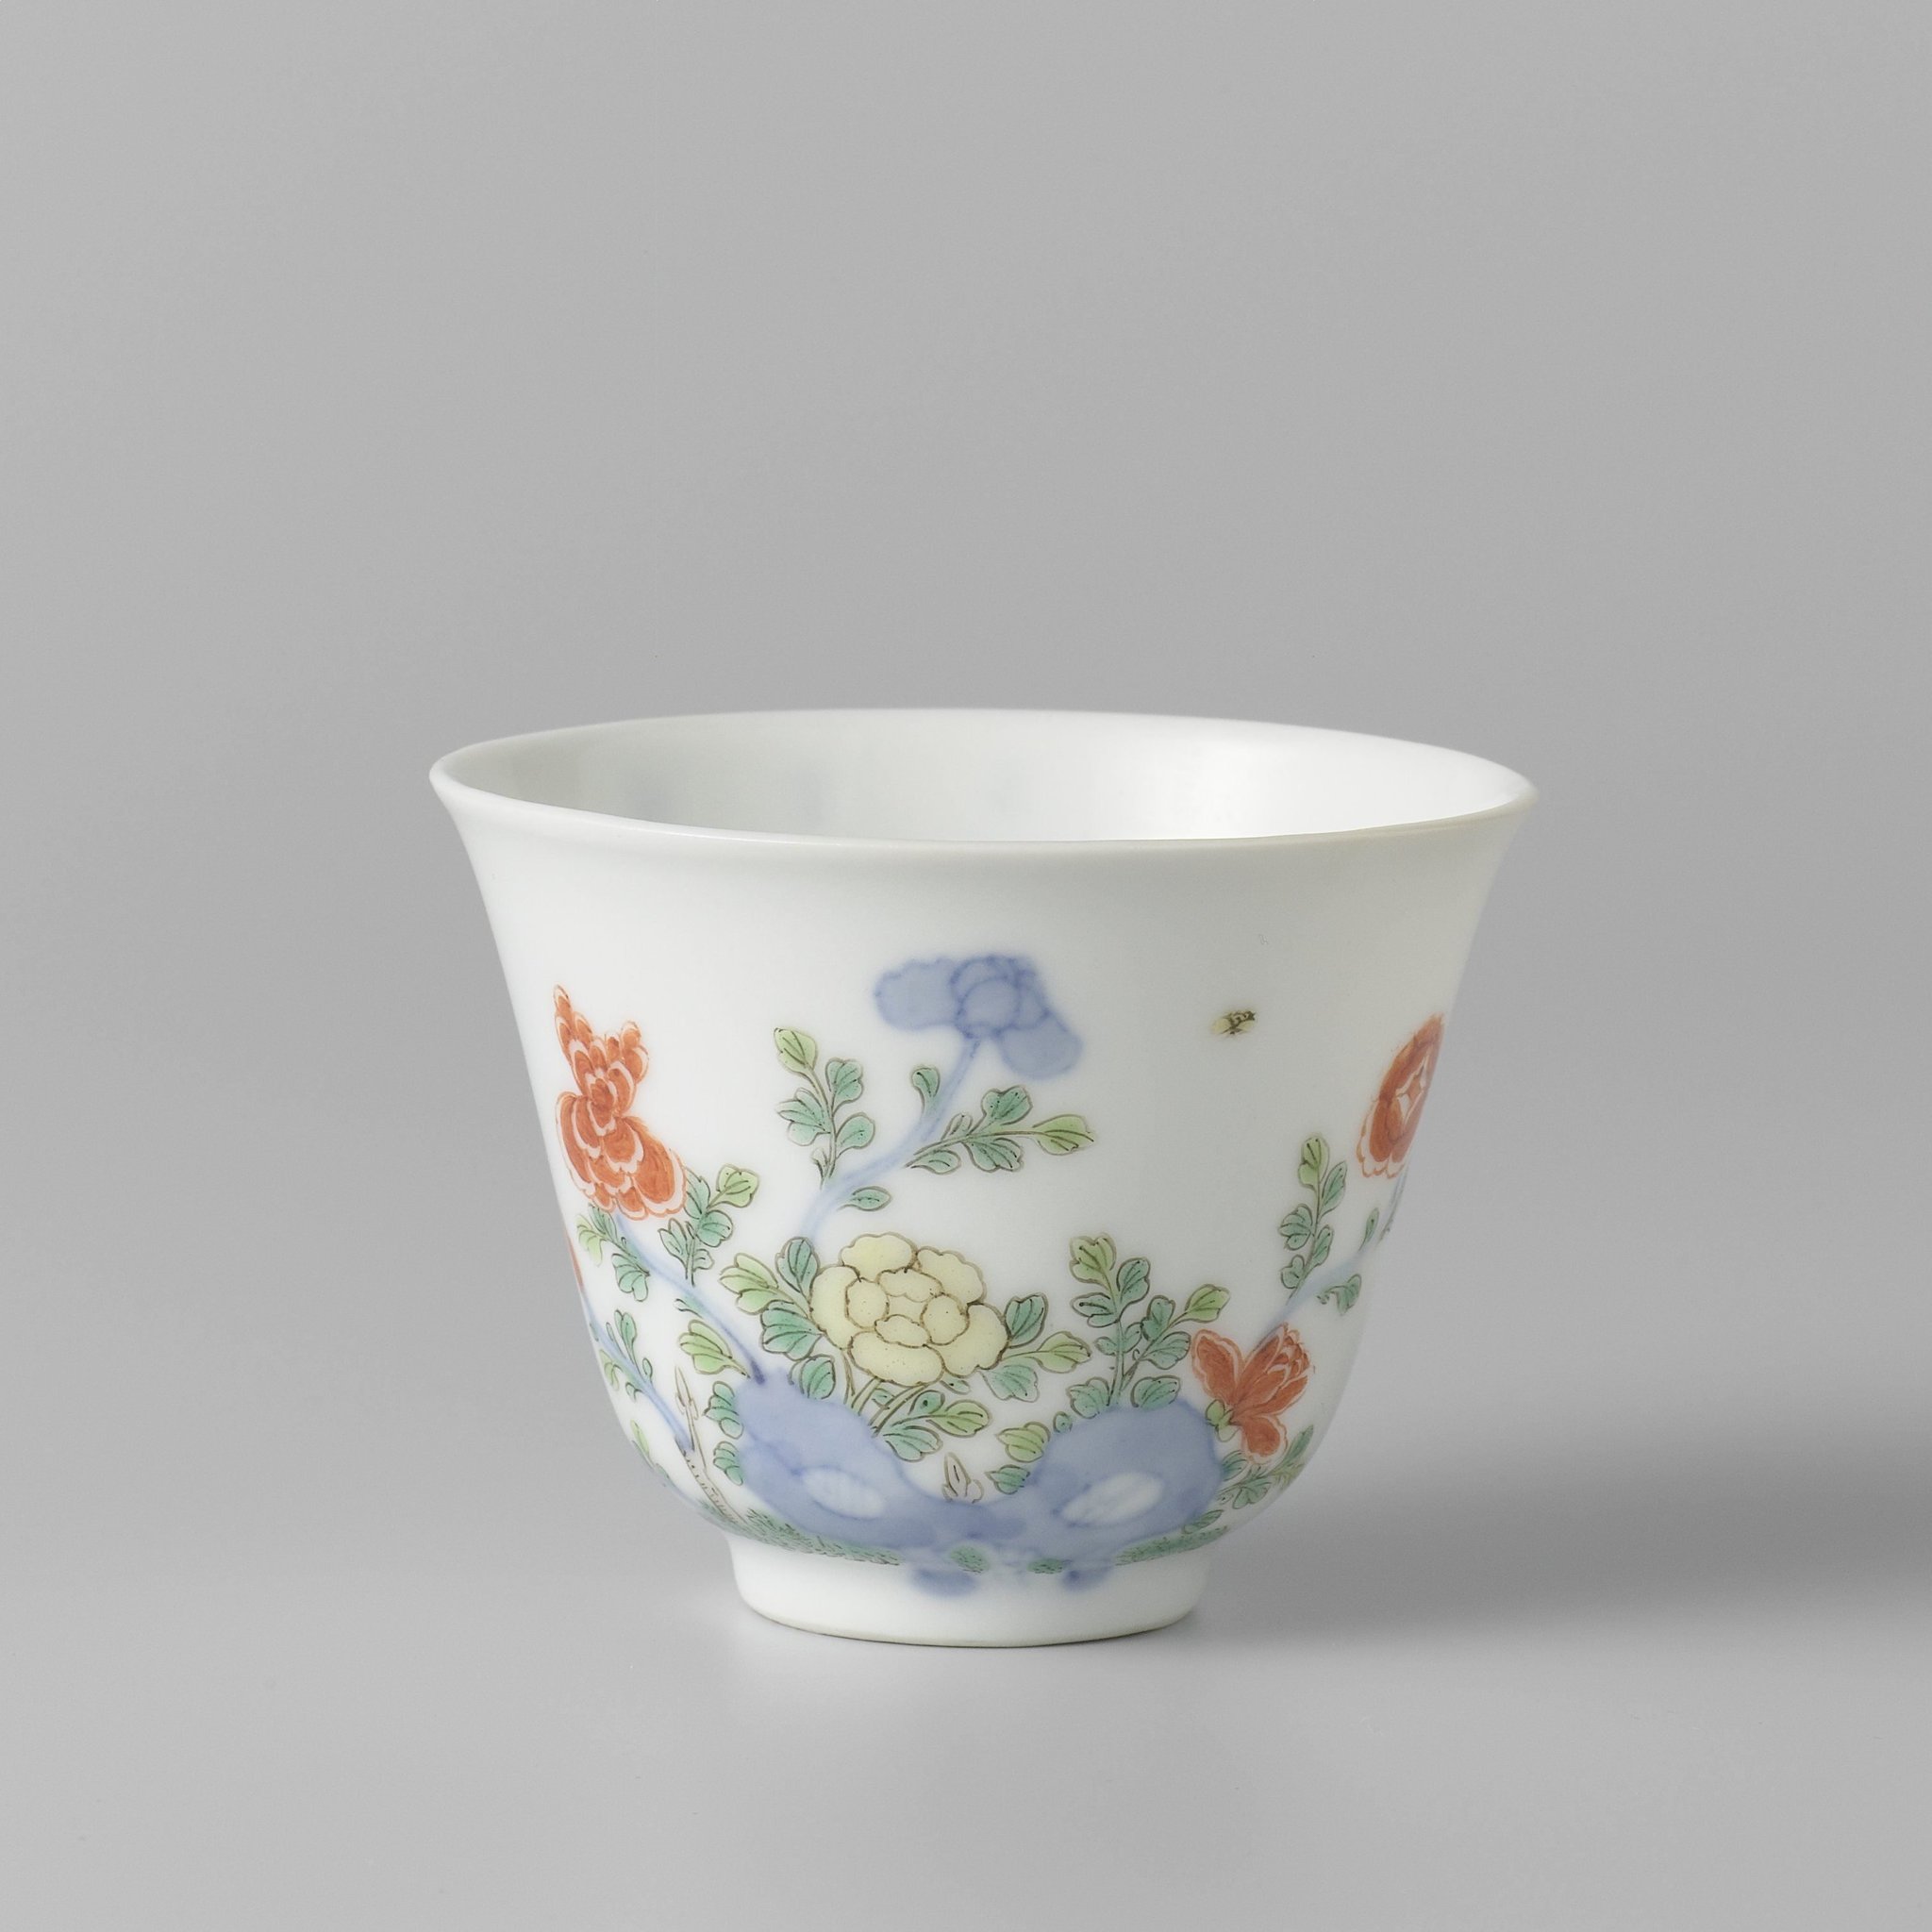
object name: cup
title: Month cup of the fourth month with a peony and a poem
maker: Anonymous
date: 1700-1724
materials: cobalt, glaze, paint, porcelain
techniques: firing, turning, vitrification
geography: china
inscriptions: mark: ‘大 清 康 熙 年 製’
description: Klokvormige kop van porselein, beschilderd in onderglazuur blauw en op het glazuur blauw, rood, groen, geel, aubergine en zwart. Maandkopje van de vierde maand met op de buitenwand een pioenplant en een tweeregelig gedicht afgesloten door het zegelmerk 'shang', waardering. Gemerkt op de onderzijde met het zes-karaktermerk van keizer Kangxi in een dubbele cirkel. Porselein met emailkleuren.